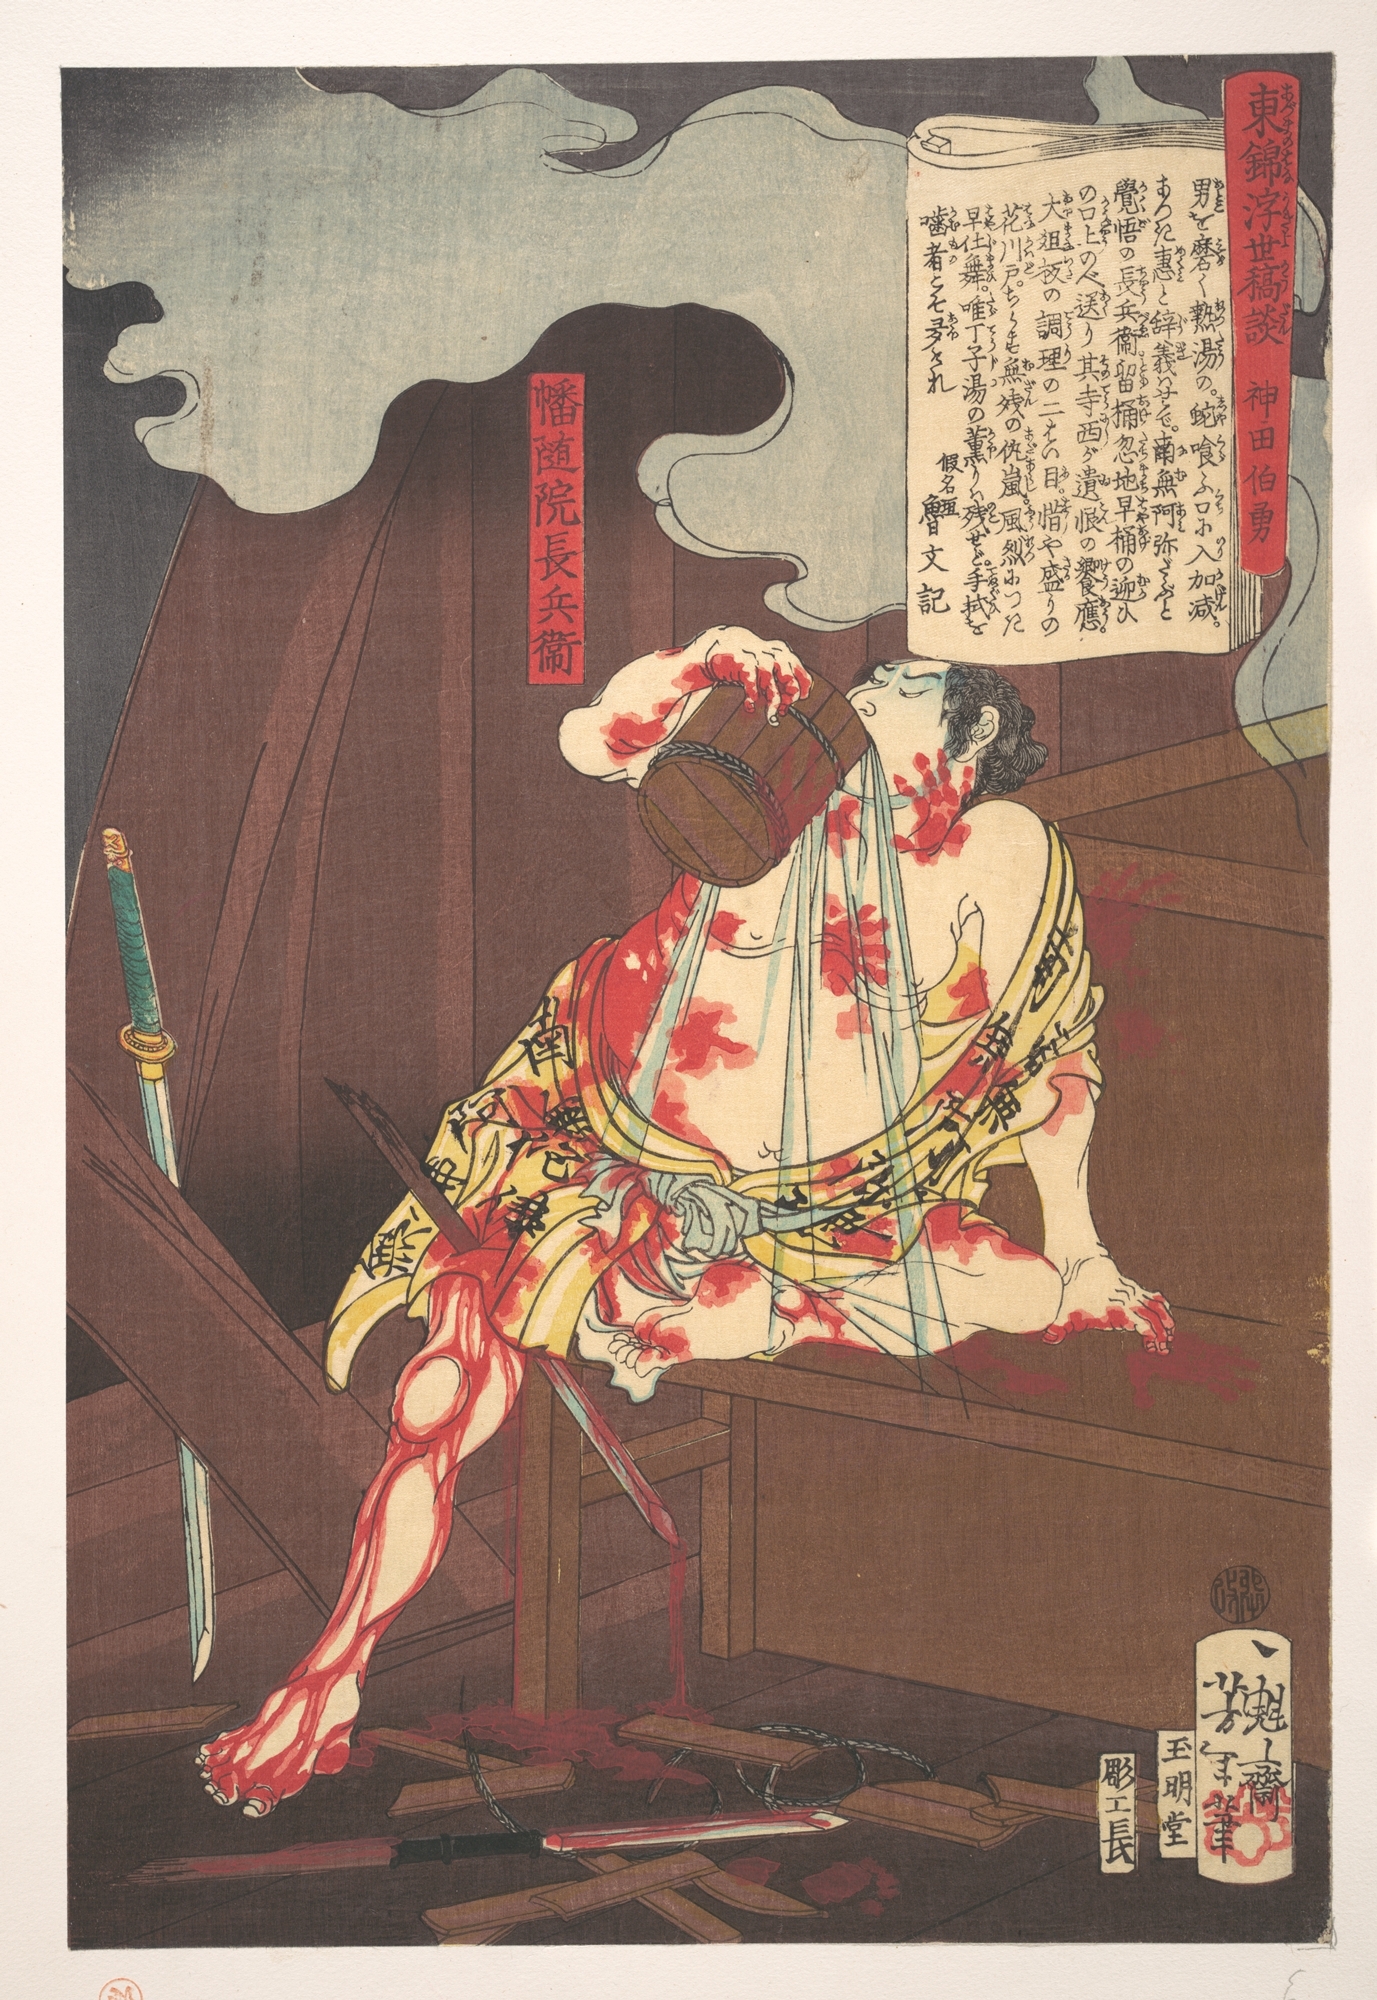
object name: print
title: Banzuiin Chōbei, from the series Story of Brocades of the East in the Floating World (Azuma no hana ukiyo kōdan - Banzuiin Chōbei)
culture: japanese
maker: tsukioka yoshitoshi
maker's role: artist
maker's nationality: japanese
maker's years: 1839-1892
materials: ink, paper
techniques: woodblock print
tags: swords,men,drinking